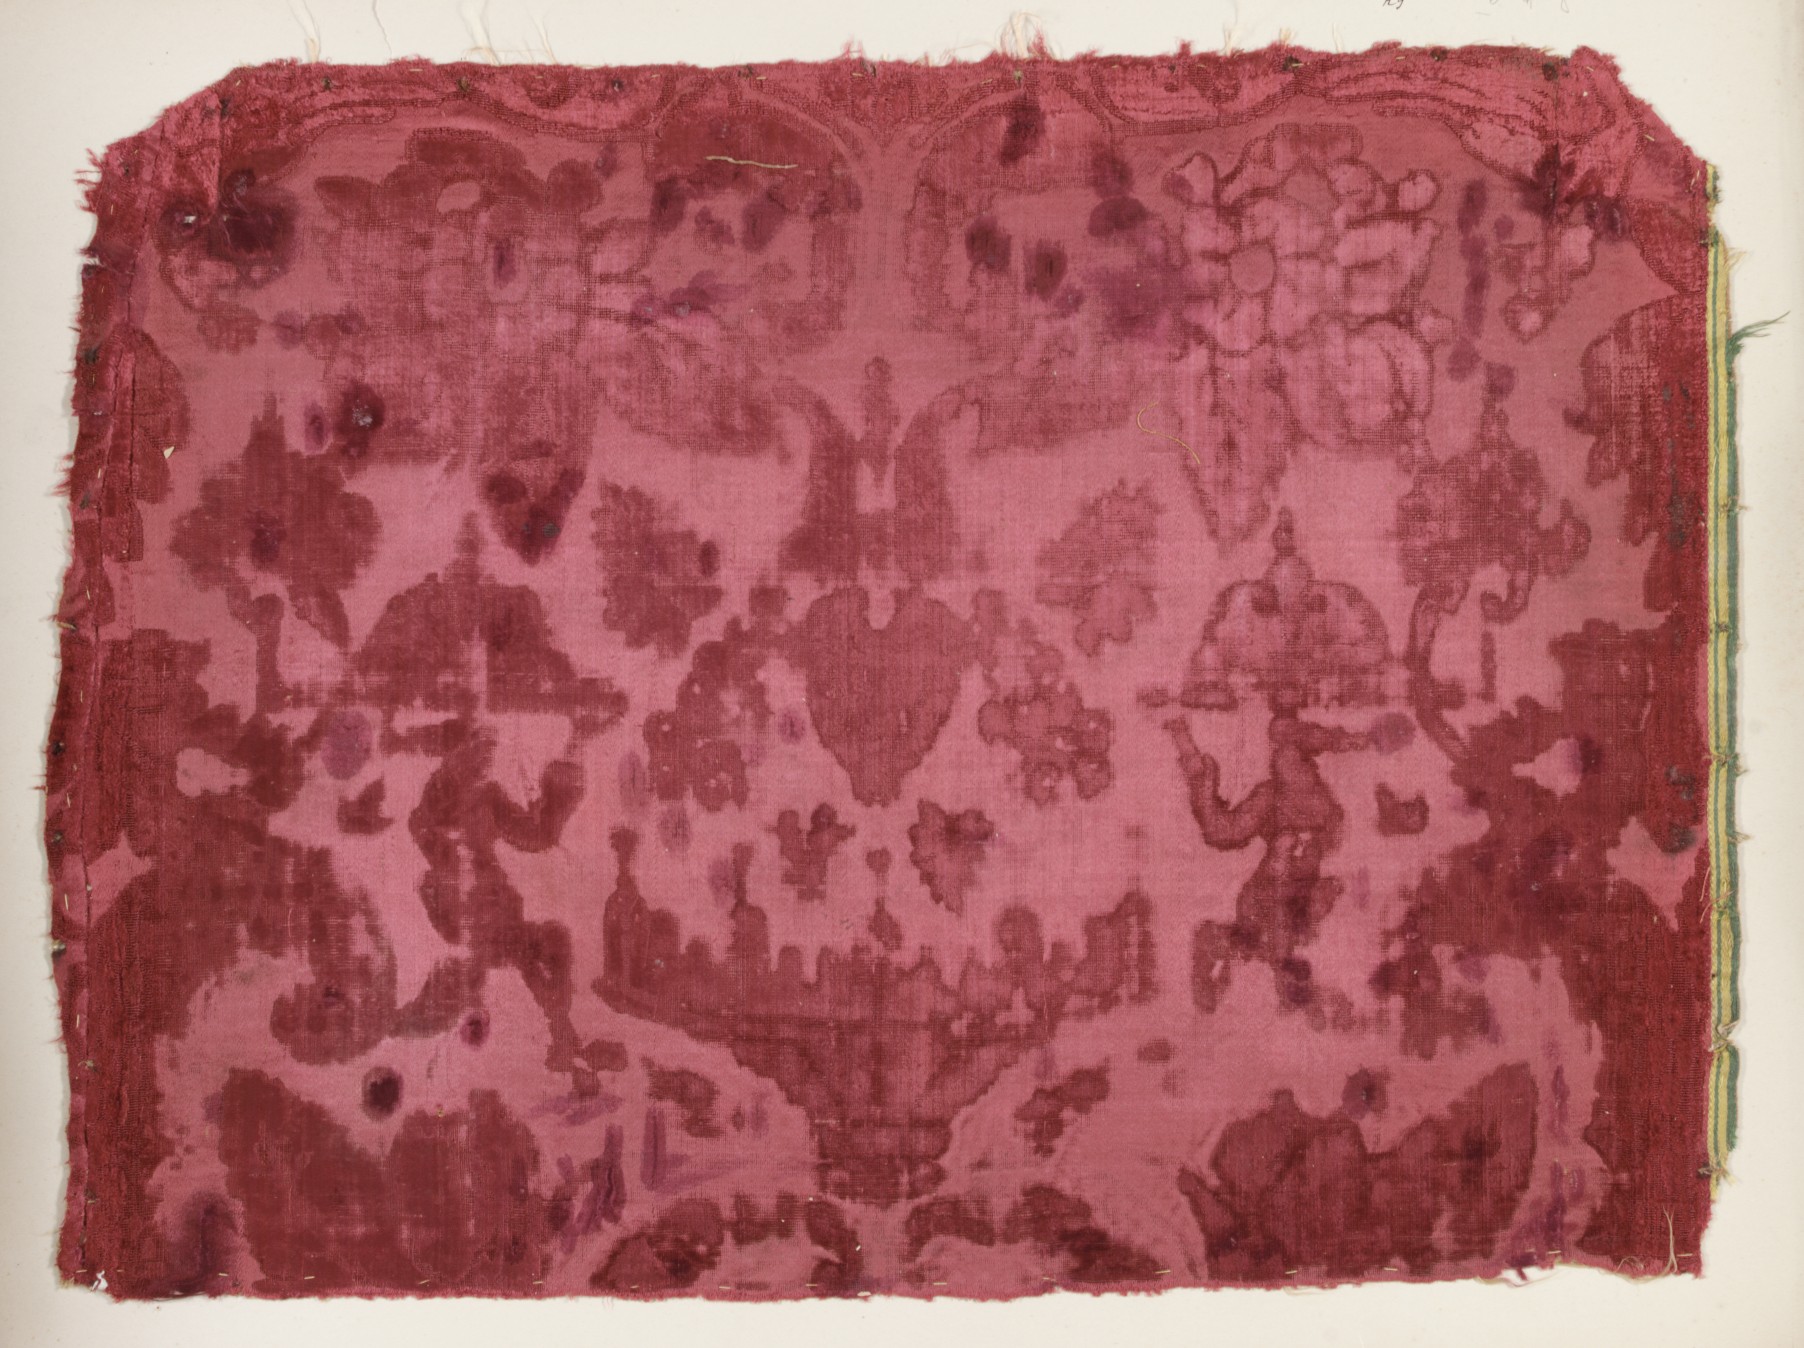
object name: fragment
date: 1601-1800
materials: silk